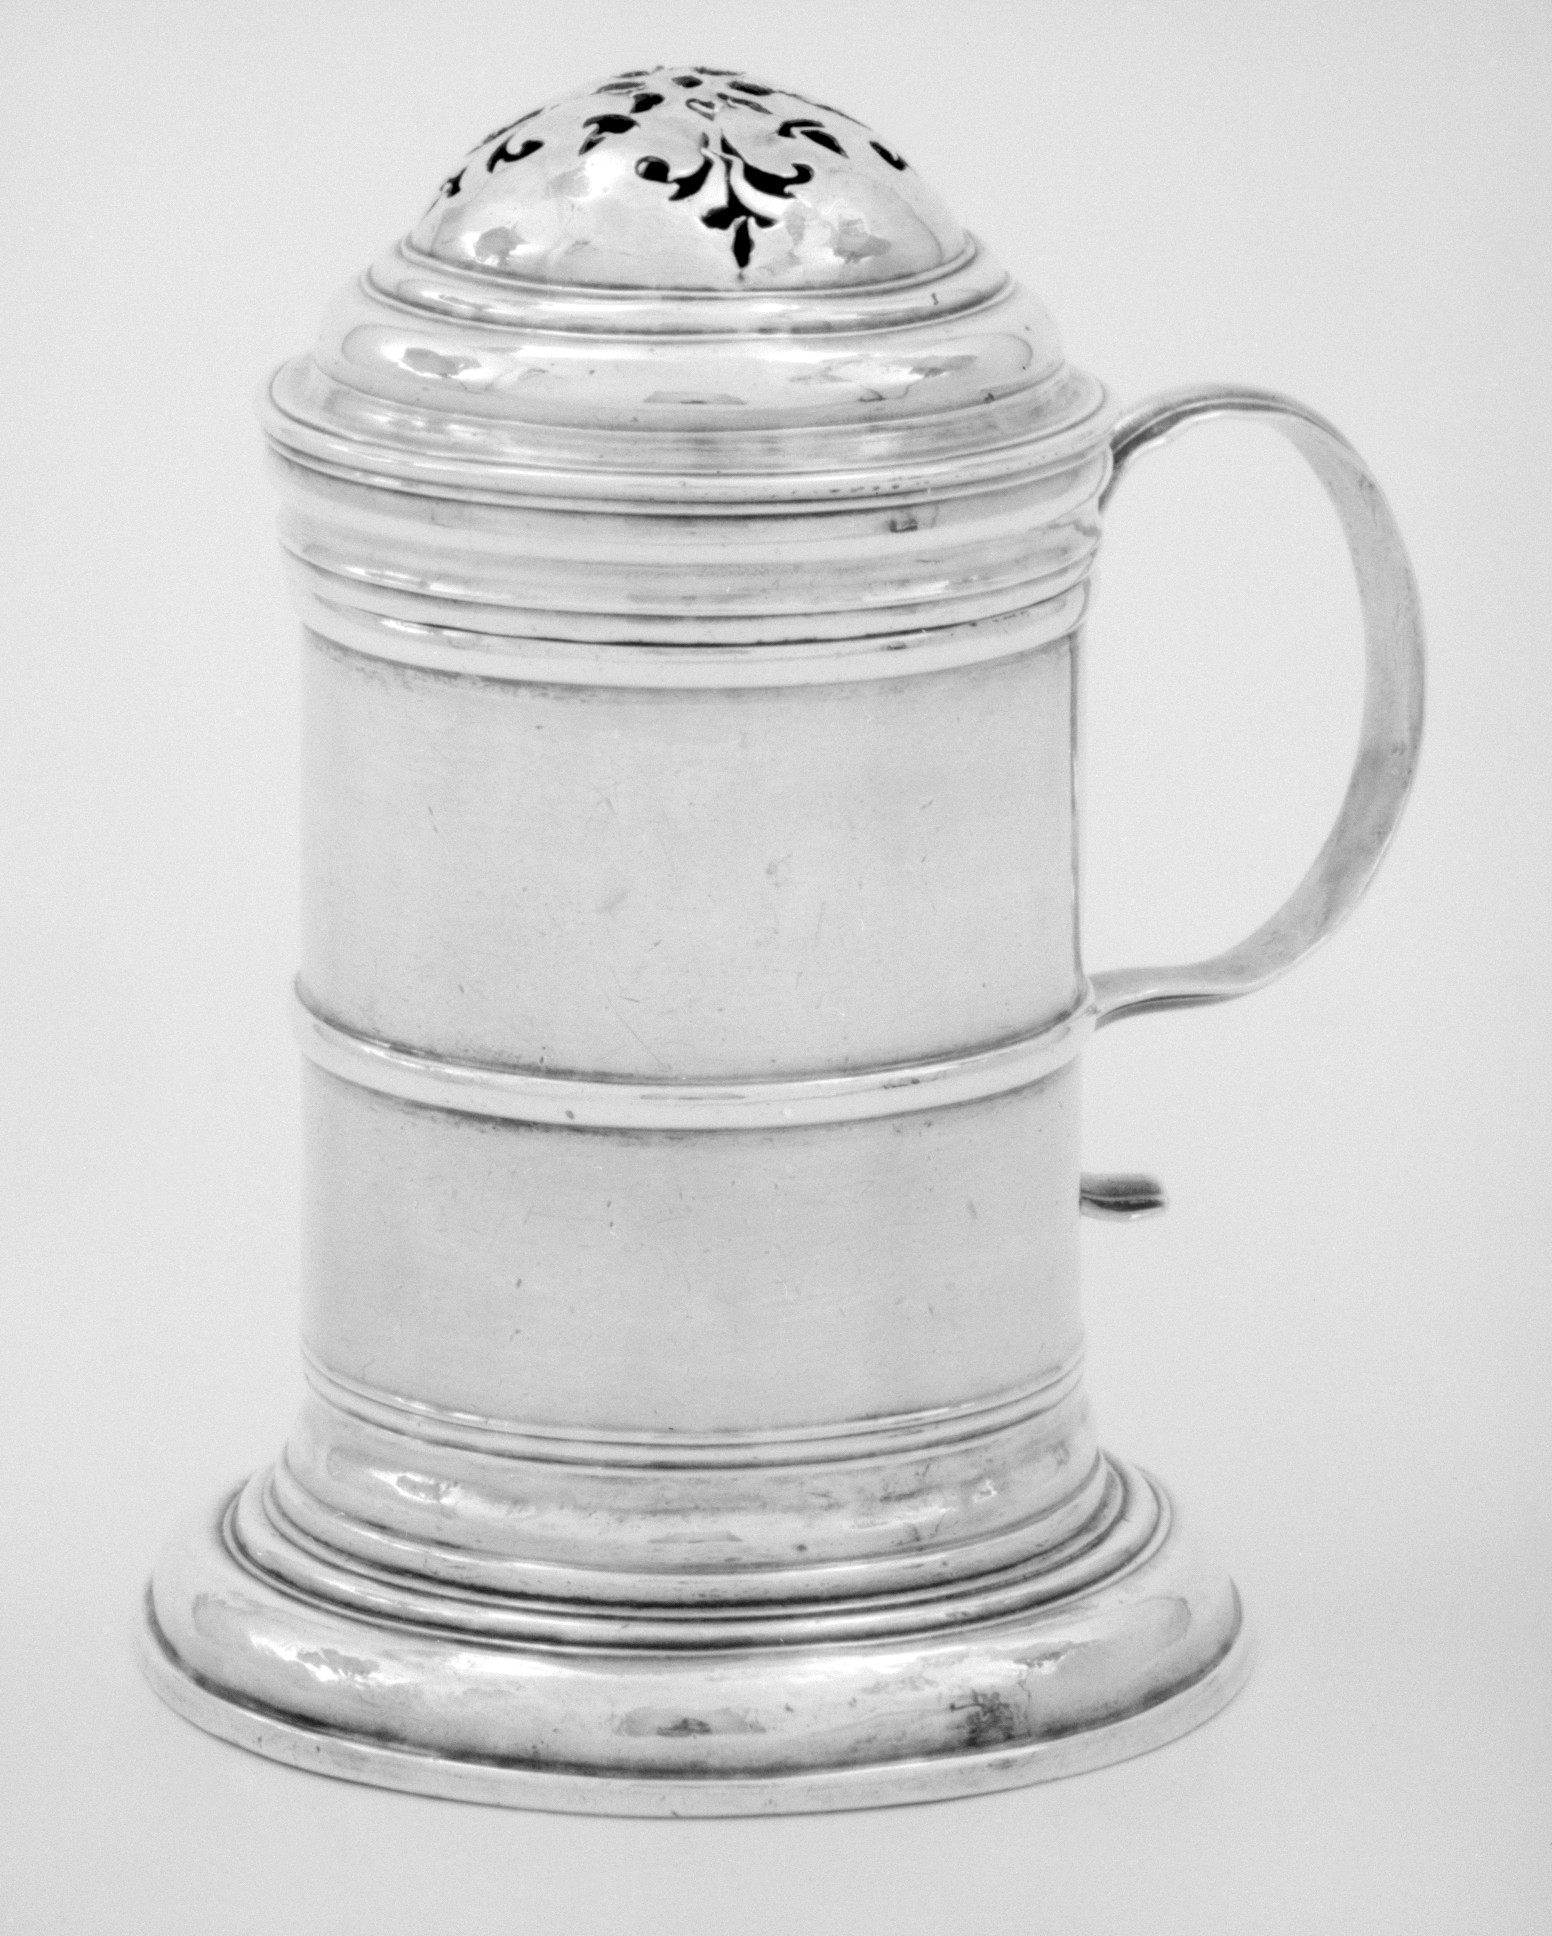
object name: caster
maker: edward turner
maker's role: maker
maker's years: 1720-1722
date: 1721-1722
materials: silver